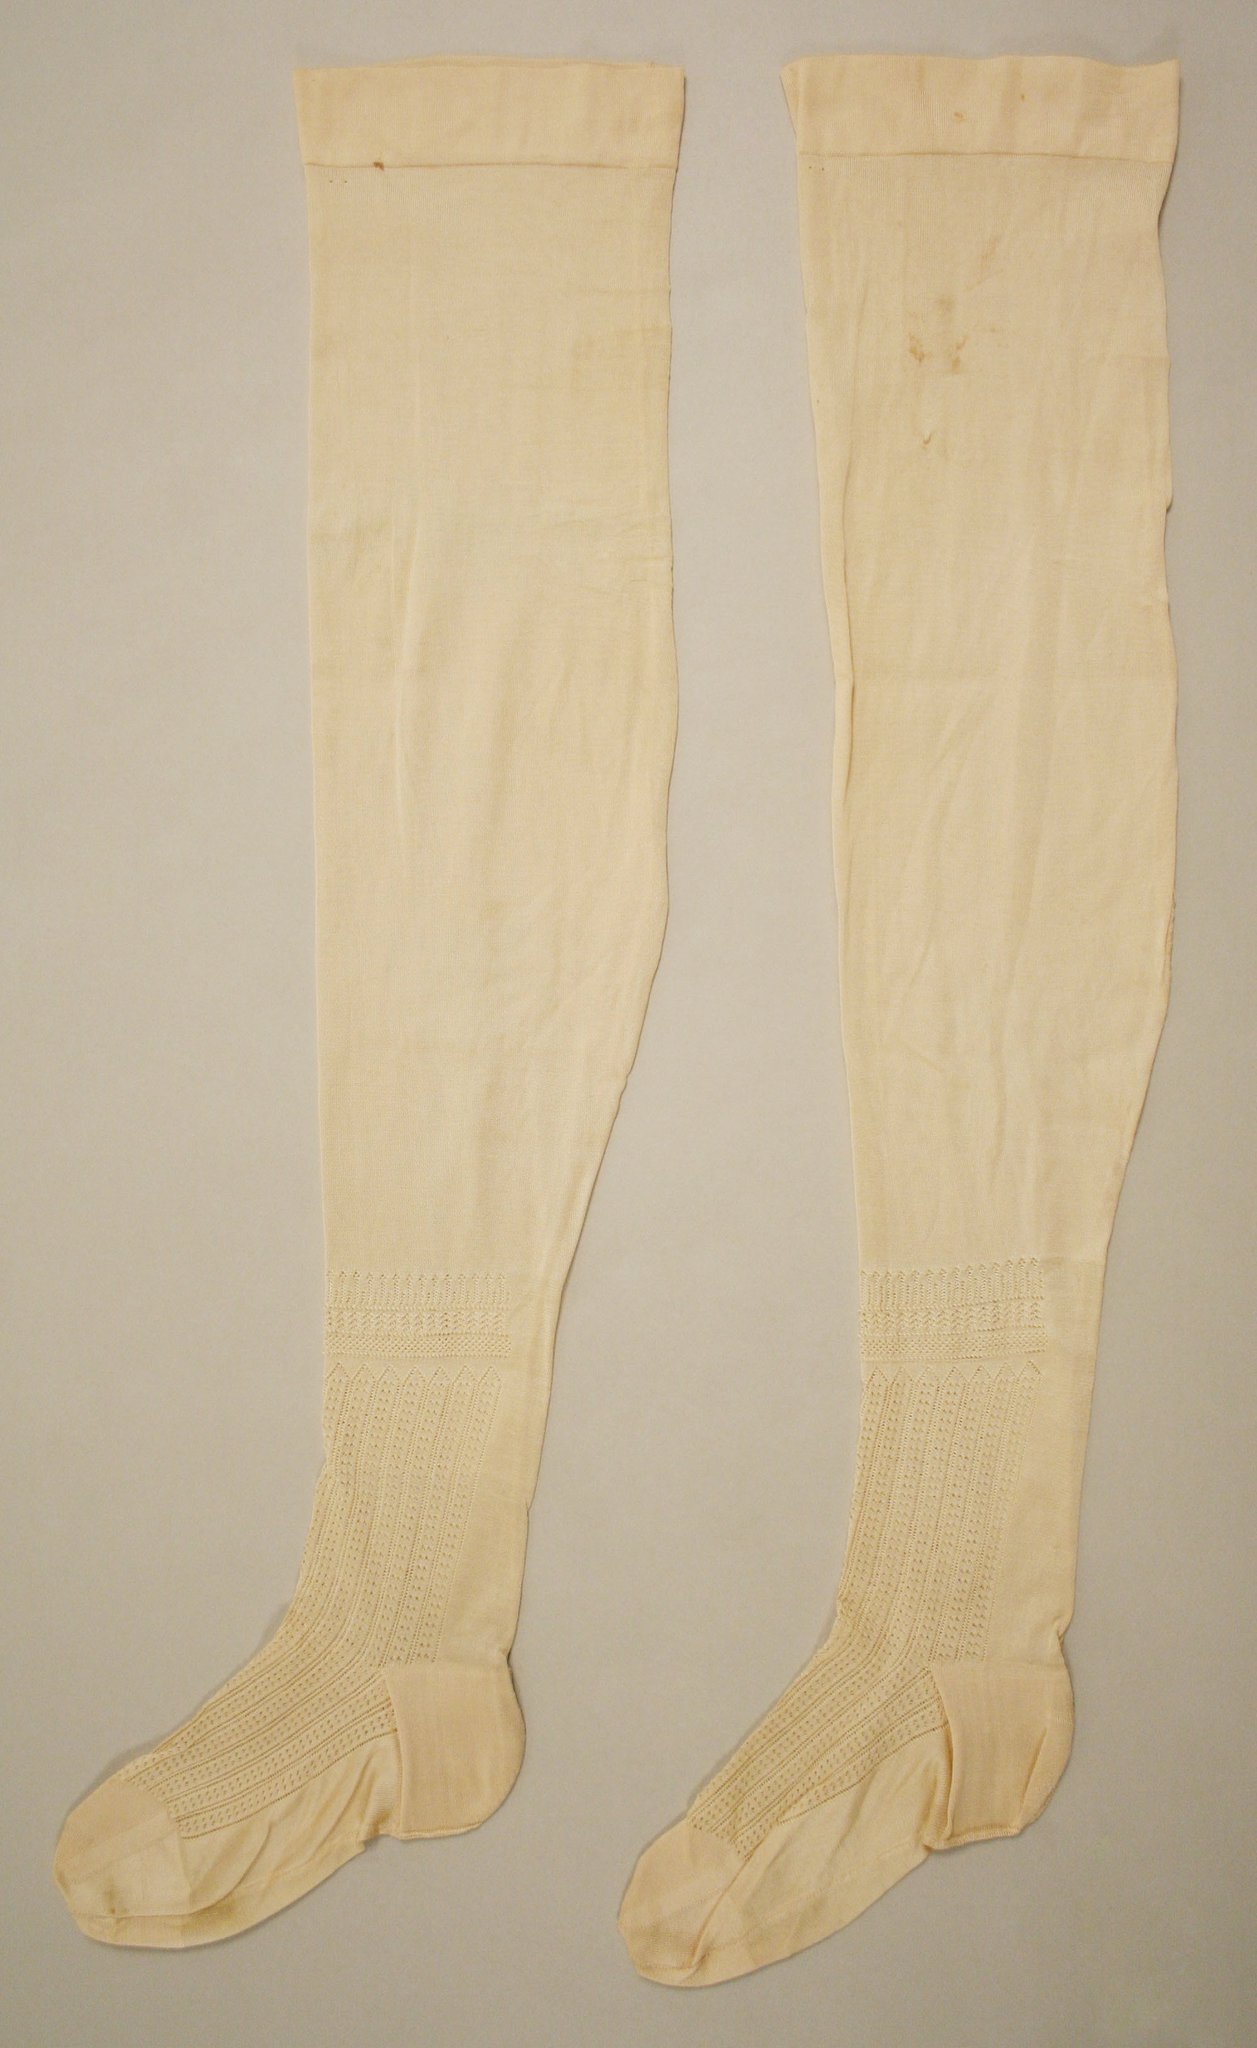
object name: stocking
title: Stockings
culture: french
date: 1894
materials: silk